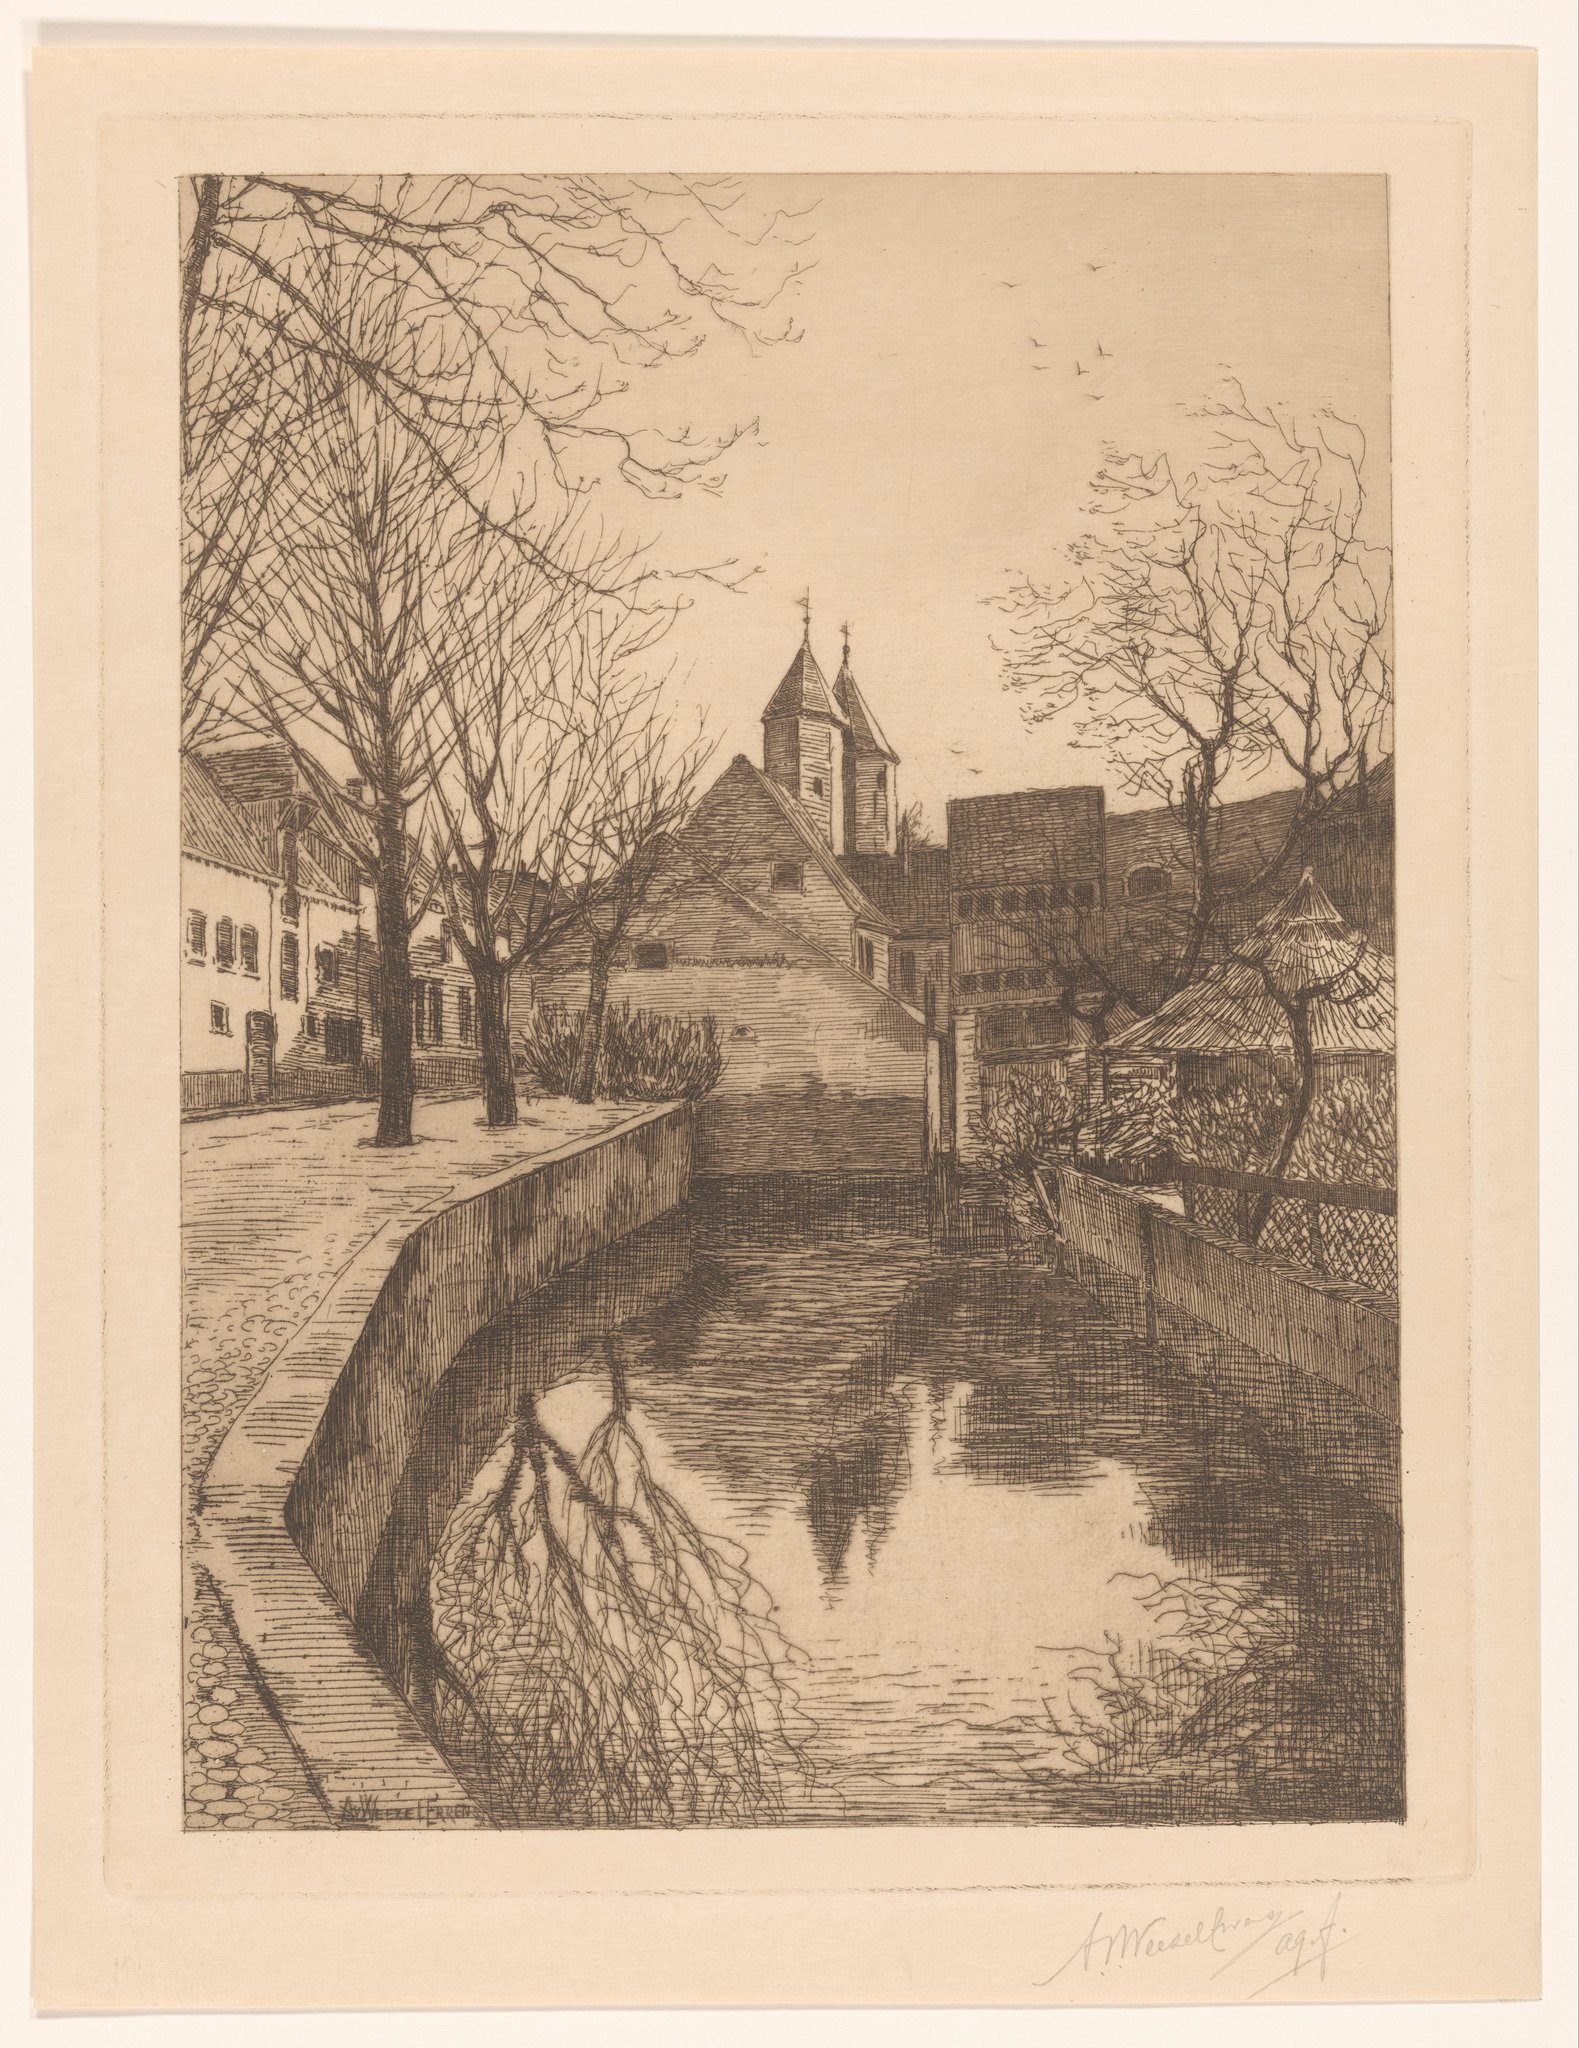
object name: print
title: Gezicht op de Kamperbinnenpoort in Amersfoort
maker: adolphe p.h j. van weezel errens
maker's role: print maker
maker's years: 1866-1939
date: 1876-1912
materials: paper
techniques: etching, intaglio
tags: city-view, and landscape with man-made constructions, canals, waters (in city), civic architecture; edifices; dwellings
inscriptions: inscription: ‘Amersfoort p/a ƒ 15,-’, collector's mark: Lugt 2228